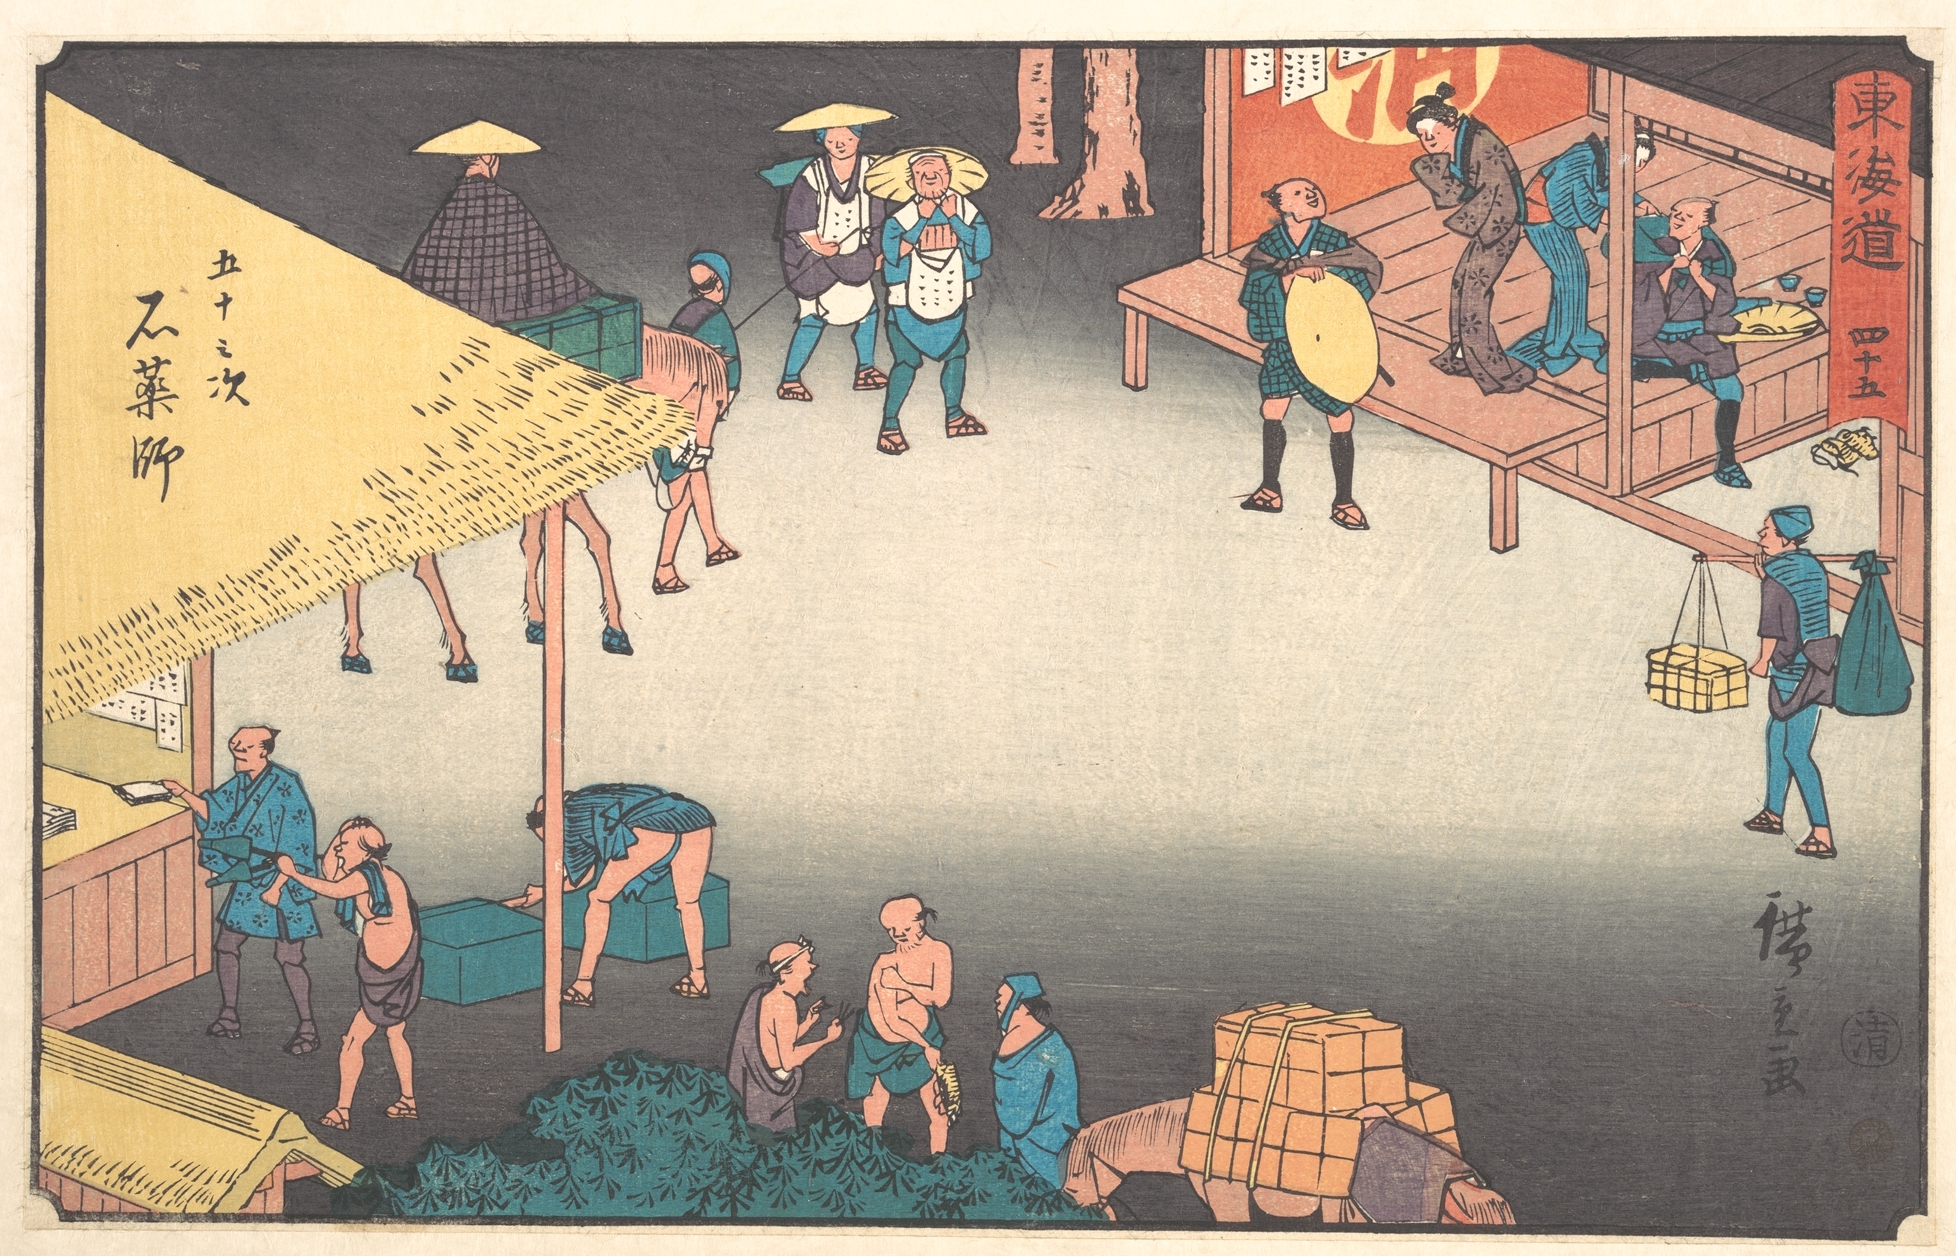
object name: print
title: Ishiyakushi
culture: japanese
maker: utagawa hiroshige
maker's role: artist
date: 1840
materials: ink, paper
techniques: woodblock print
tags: men,women,horses